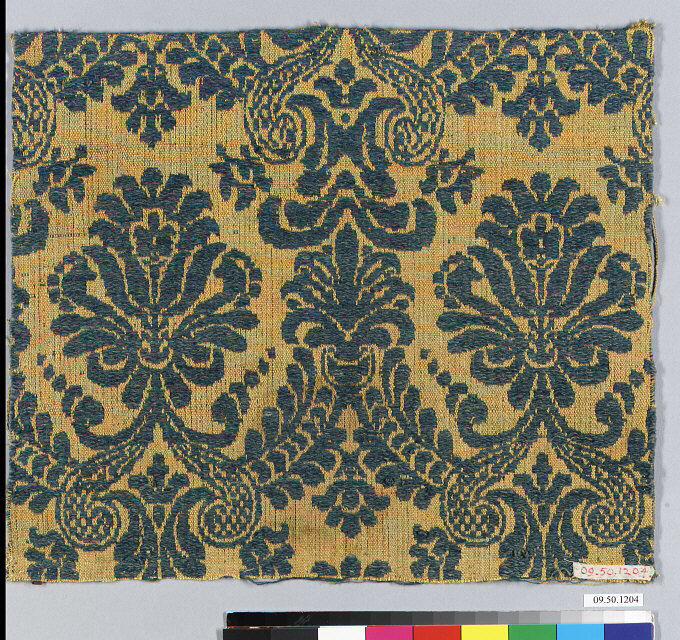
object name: piece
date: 1801-1900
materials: cotton, silk